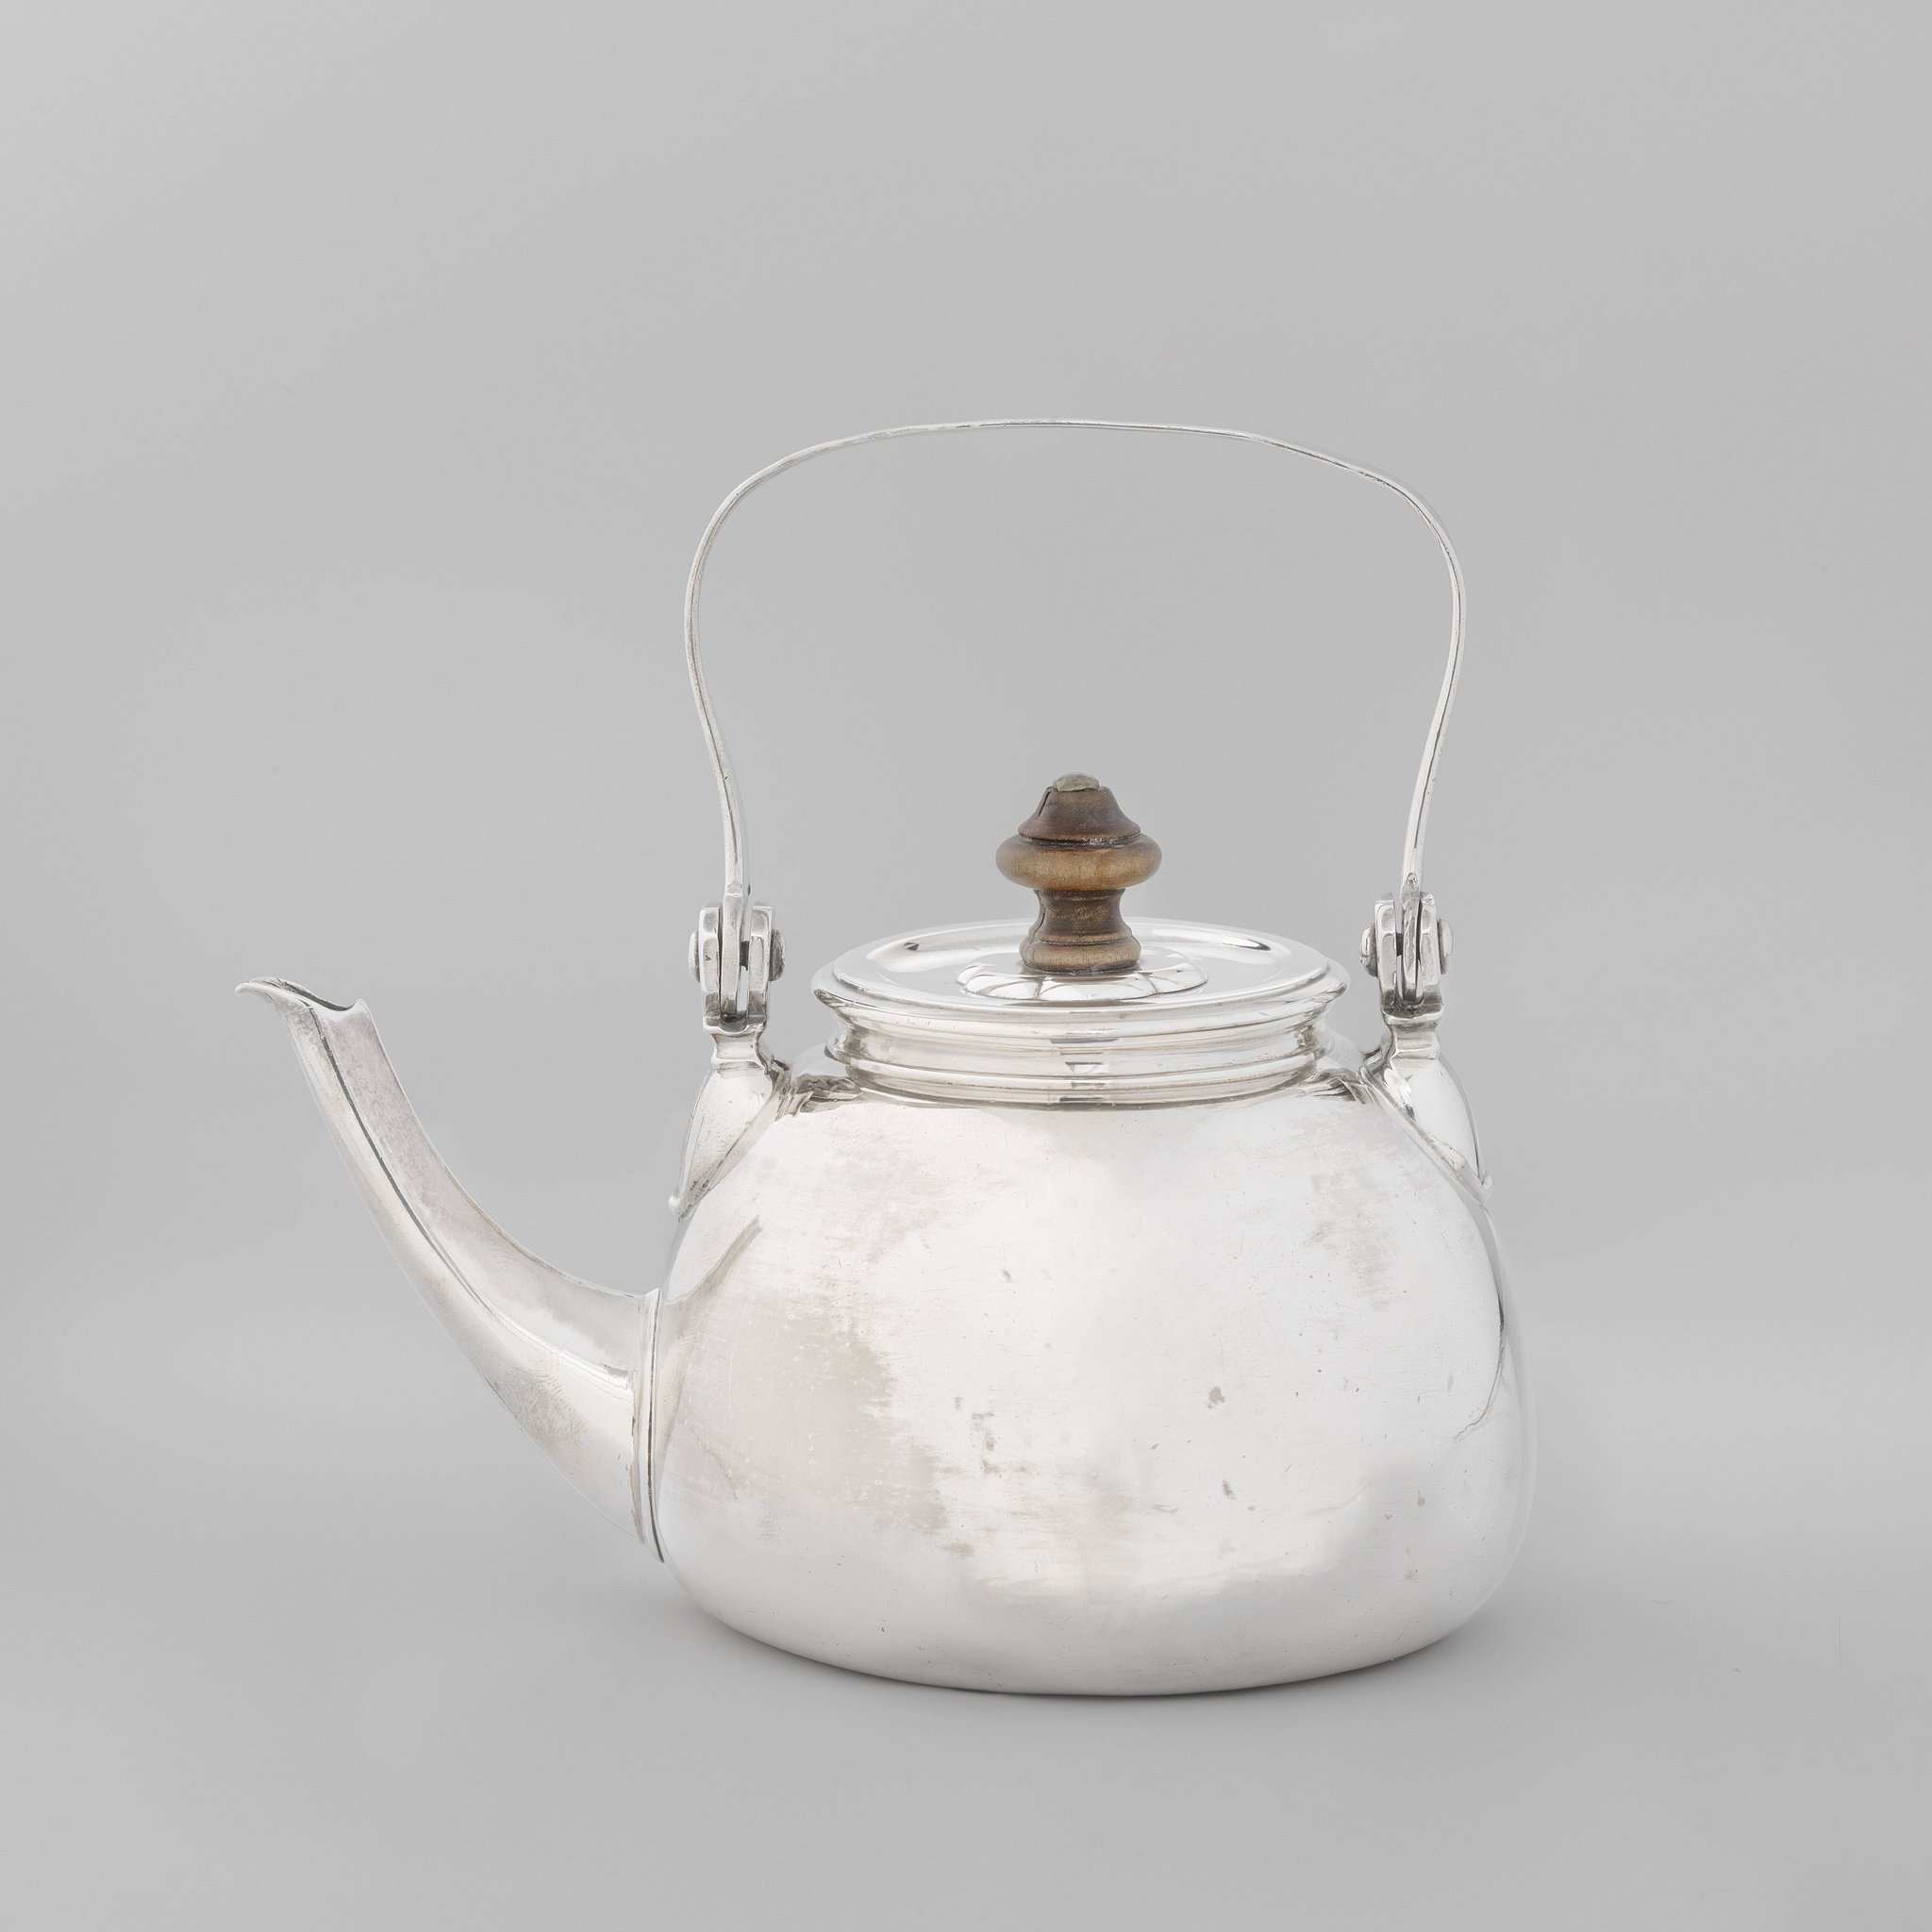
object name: teakettle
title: Theeketel van zilver met gegraveerde wapen van de familie Beaumont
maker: gerardus cornelii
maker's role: jeweler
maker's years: 1695-1745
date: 1744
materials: silver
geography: nijmegen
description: Theeketel van zilver. Het bolle vat is afgeplat aan de onderkant van waaruit de tuit met een flauwe buiging omhoog rijst. Op een der hengsel-aanzetstukken het gegraveerde wapen van de familie Beaumont.